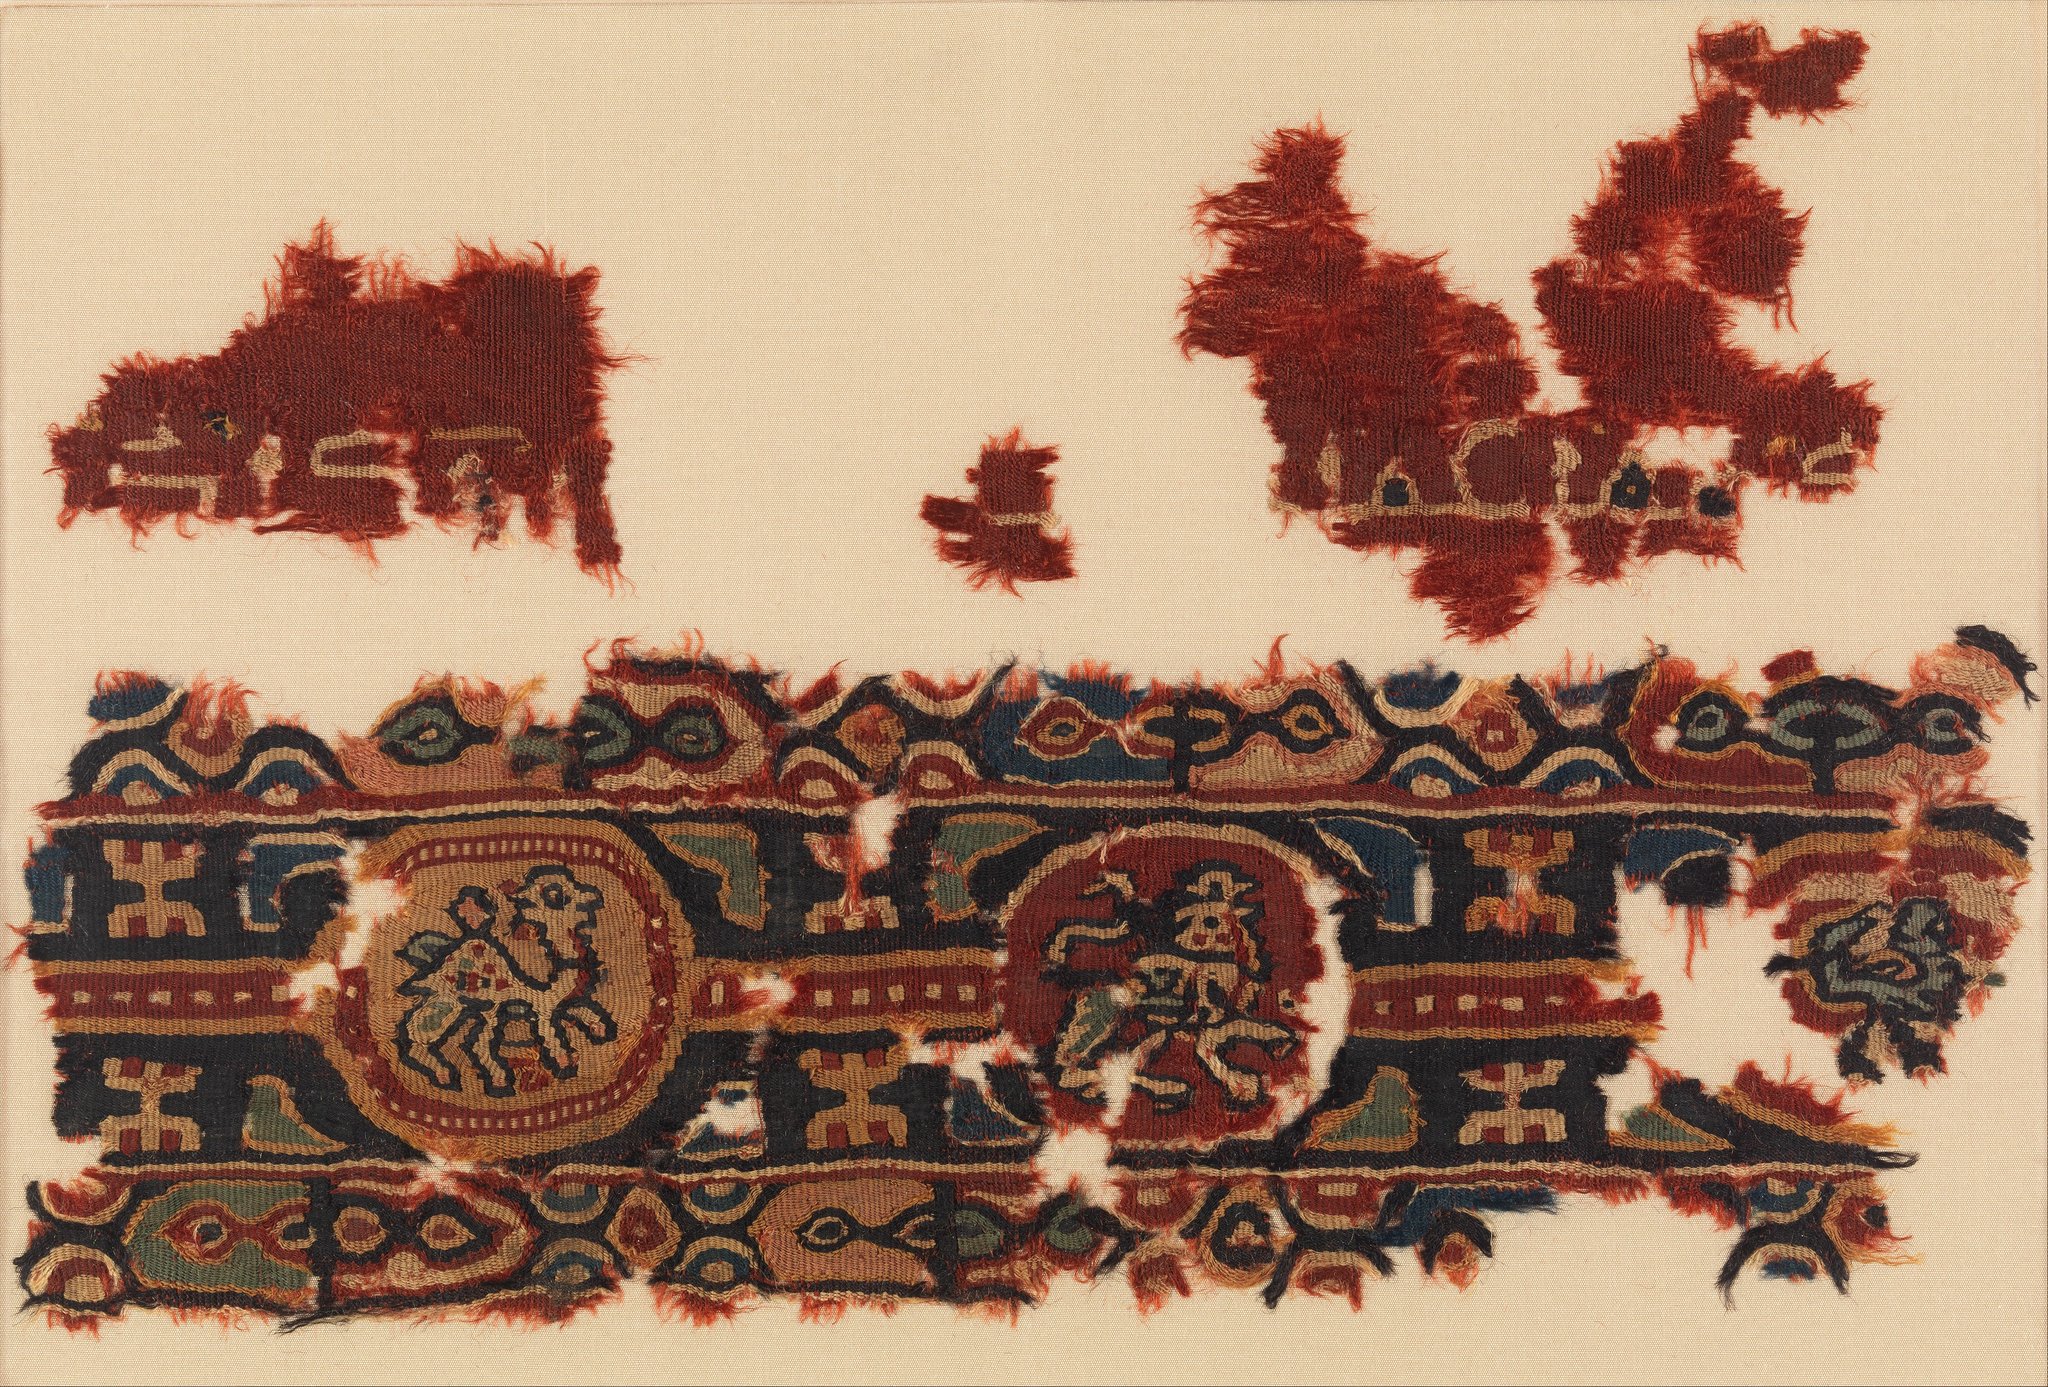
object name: tiraz fragment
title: Tiraz with Medallions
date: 701-900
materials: wool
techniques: weave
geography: egypt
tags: animals,camels